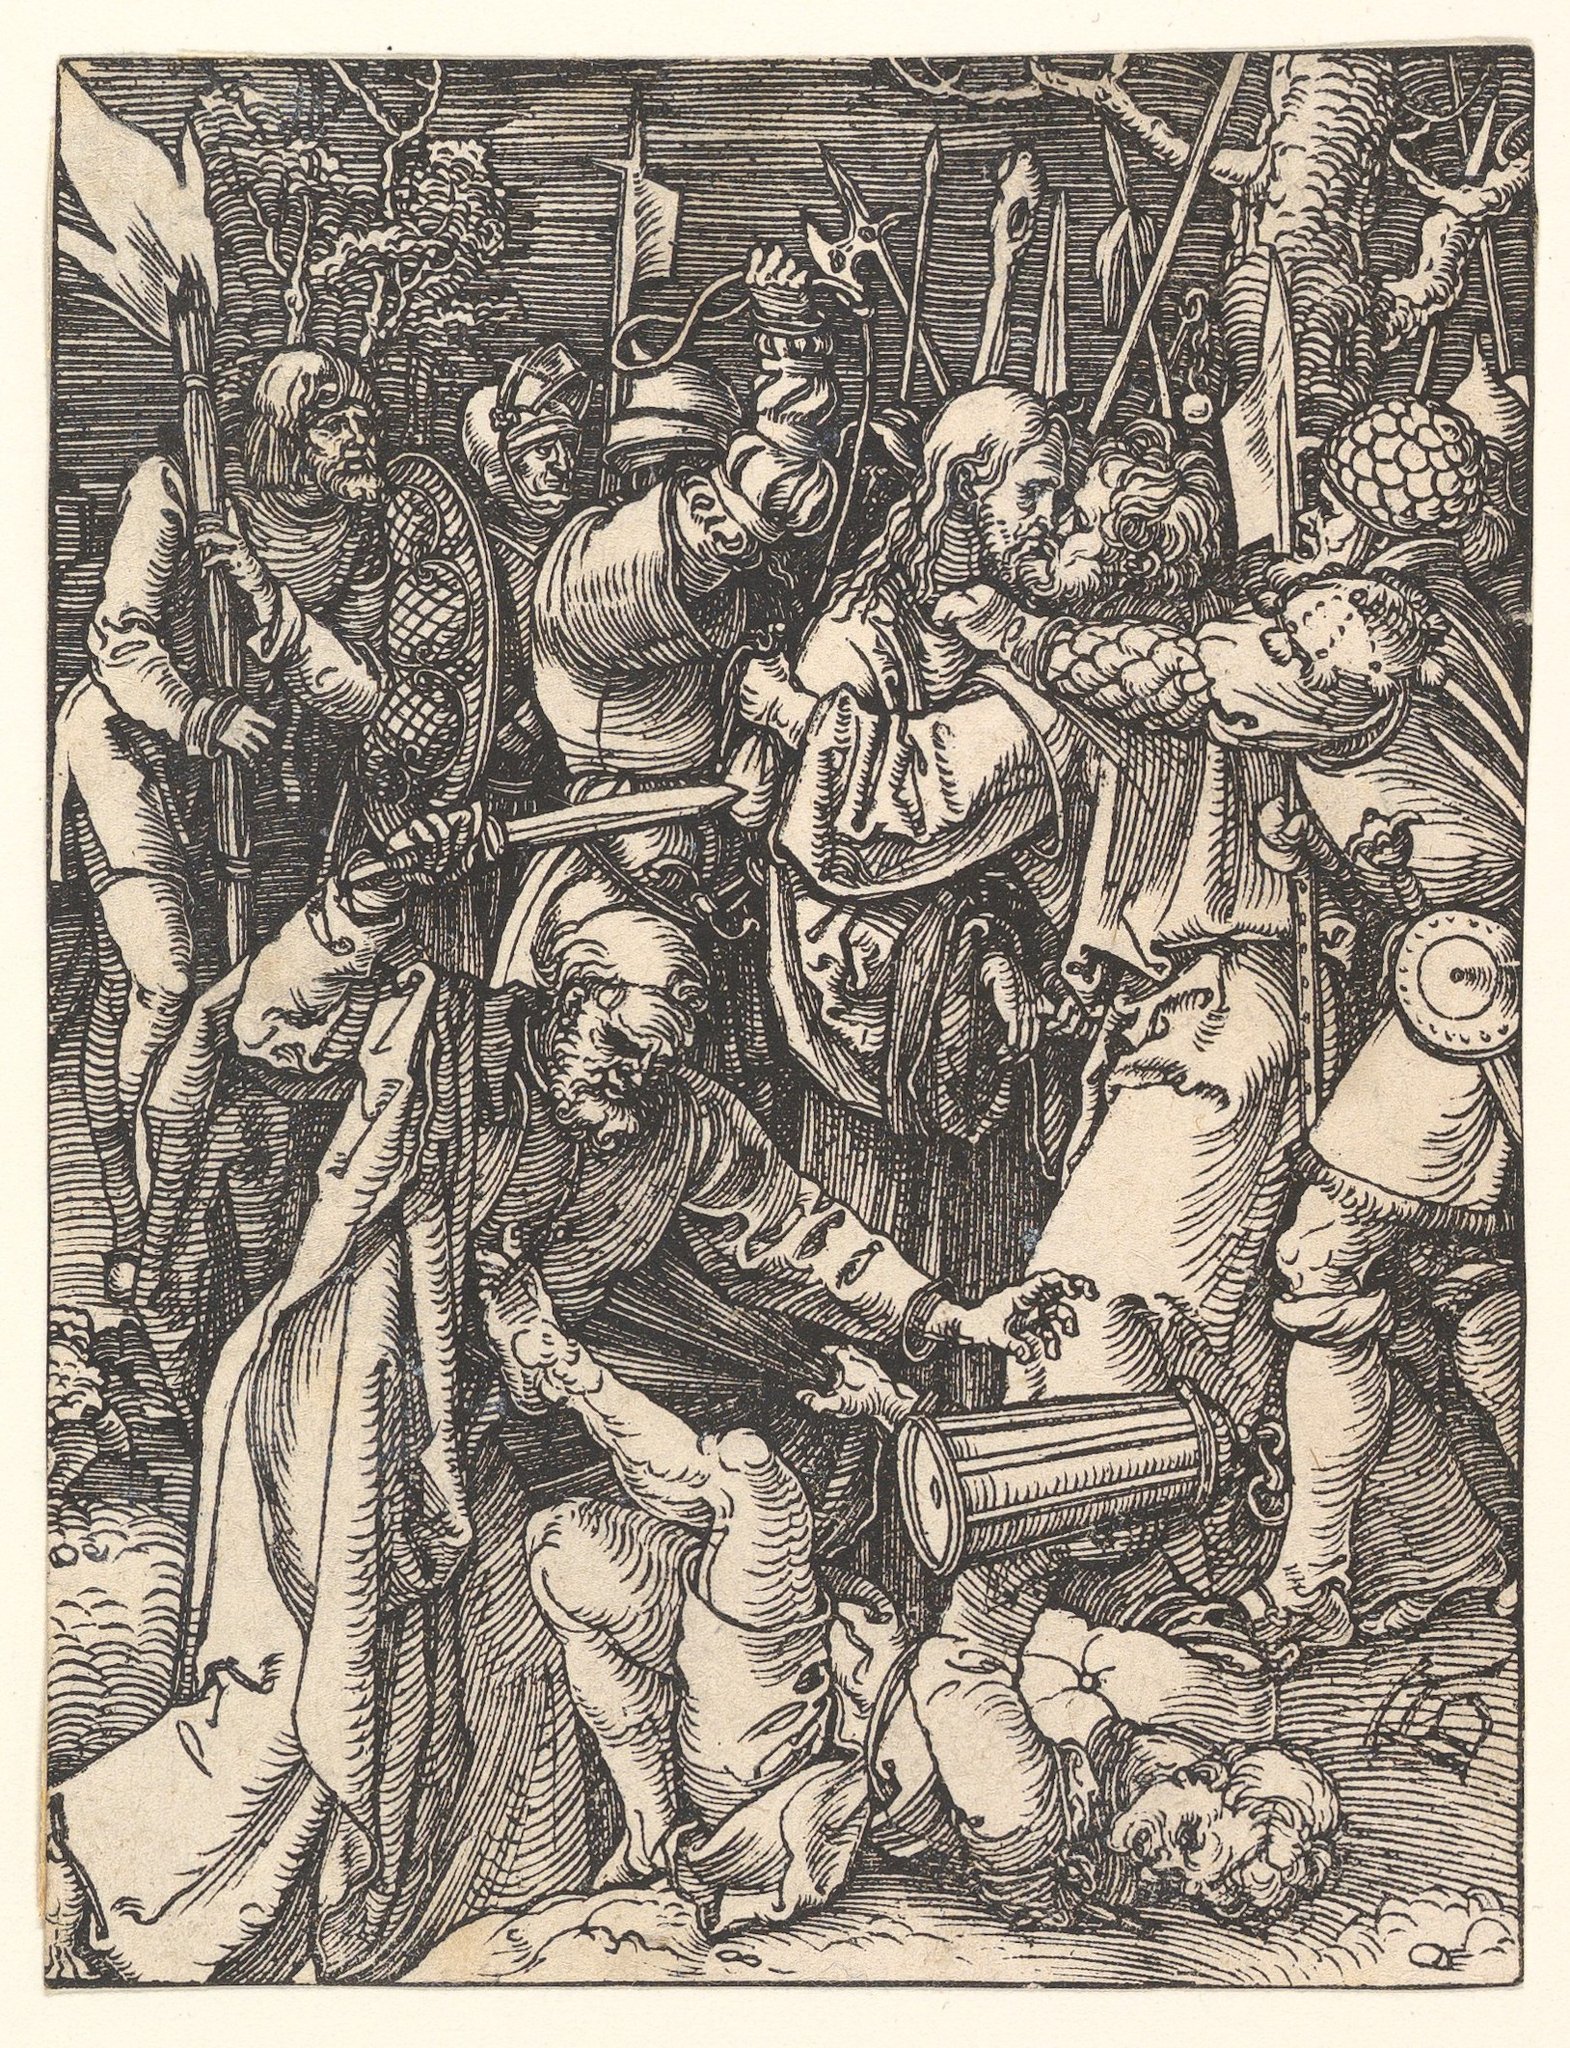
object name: print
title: The Betrayal of Christ, from "The Small Passion"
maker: albrecht dürer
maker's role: artist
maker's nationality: german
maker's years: 1471-1528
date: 1509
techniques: woodcut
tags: weapons,men,jesus